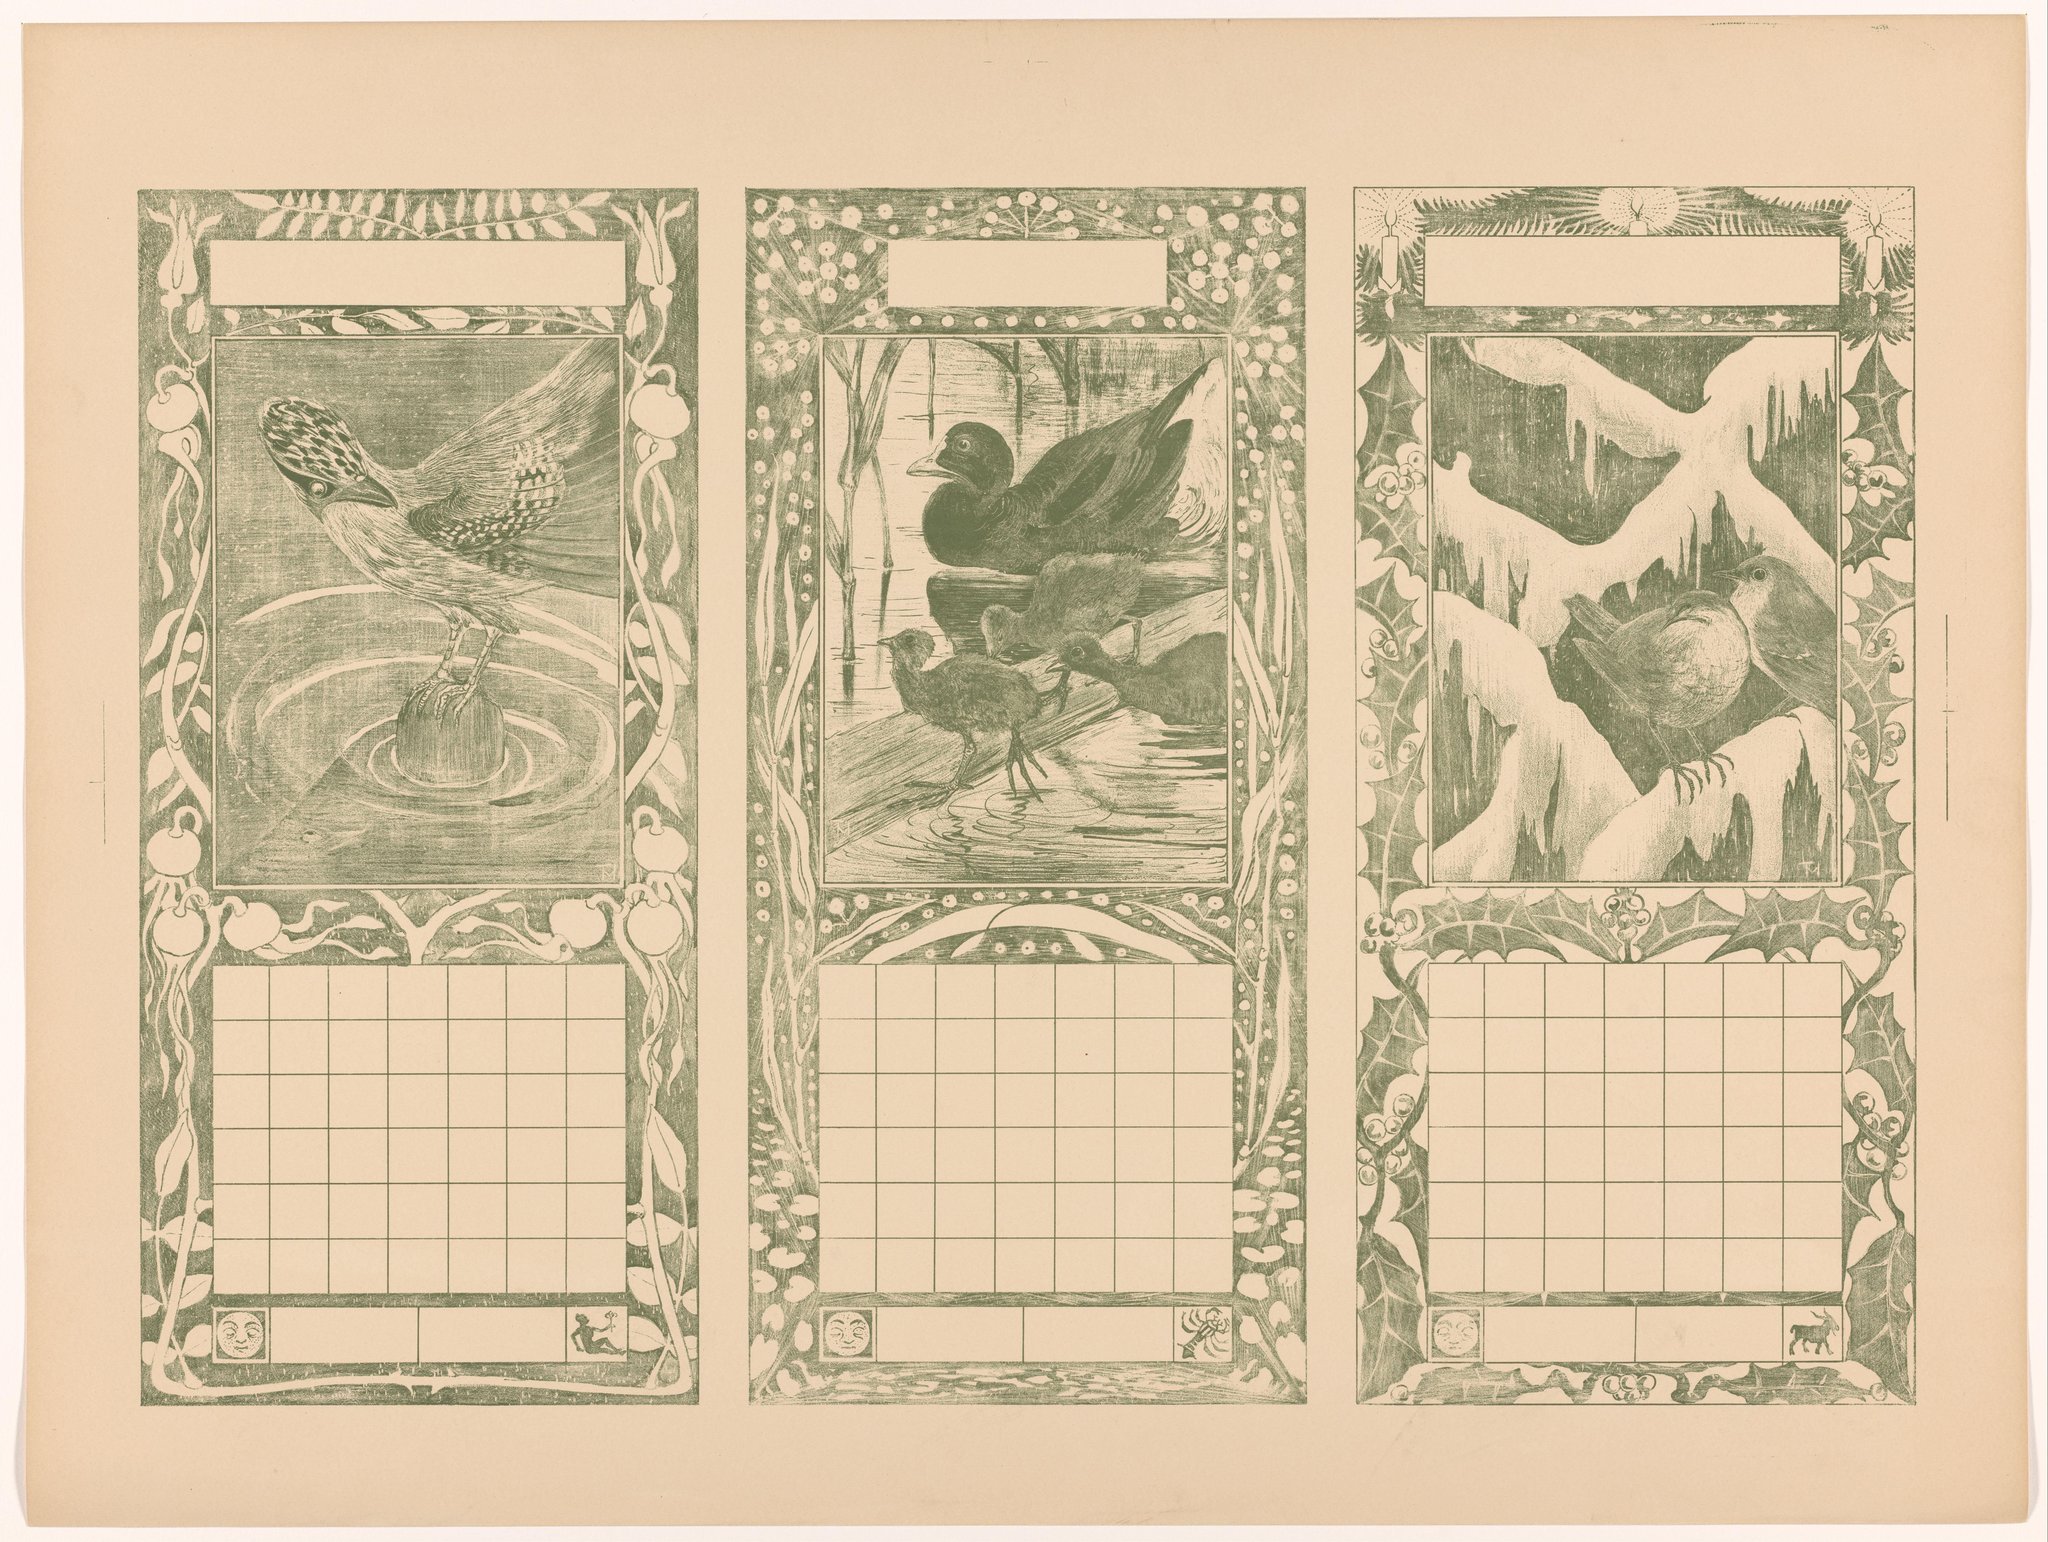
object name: print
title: Kalenders voor augustus, juni en december 1904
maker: theo van hoytema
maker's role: draughtsman, painter, print maker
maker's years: 1863-1917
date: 1904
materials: paper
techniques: lithograph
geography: amsterdam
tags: calendar, almanac, water-birds: swamp-hen, song-birds: robin, song-birds: jay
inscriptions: collector's mark: Lugt 2233